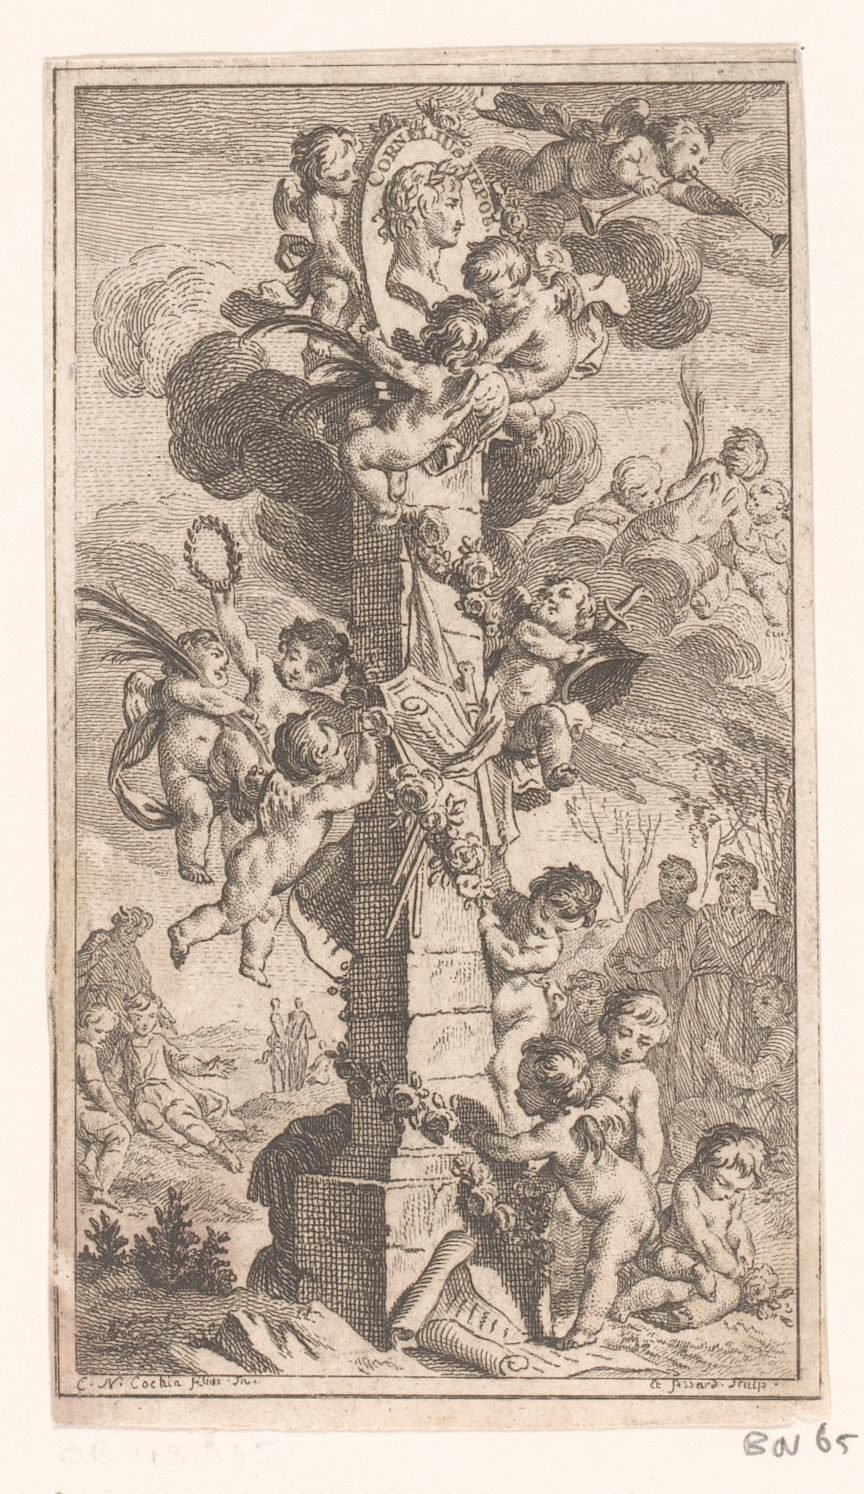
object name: print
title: Putti versieren stèle met guirlandes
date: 1745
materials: paper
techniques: etching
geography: paris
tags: upright gravestone, cupids: 'amores', 'amoretti', 'putti'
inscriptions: collector's mark: Lugt 2228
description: Prent uit: Nepos, Cornelius en Prétot, Étienne André Philippe de. De vita excellentium imperatorum. Parijs: Michel Étienne David, 1745.